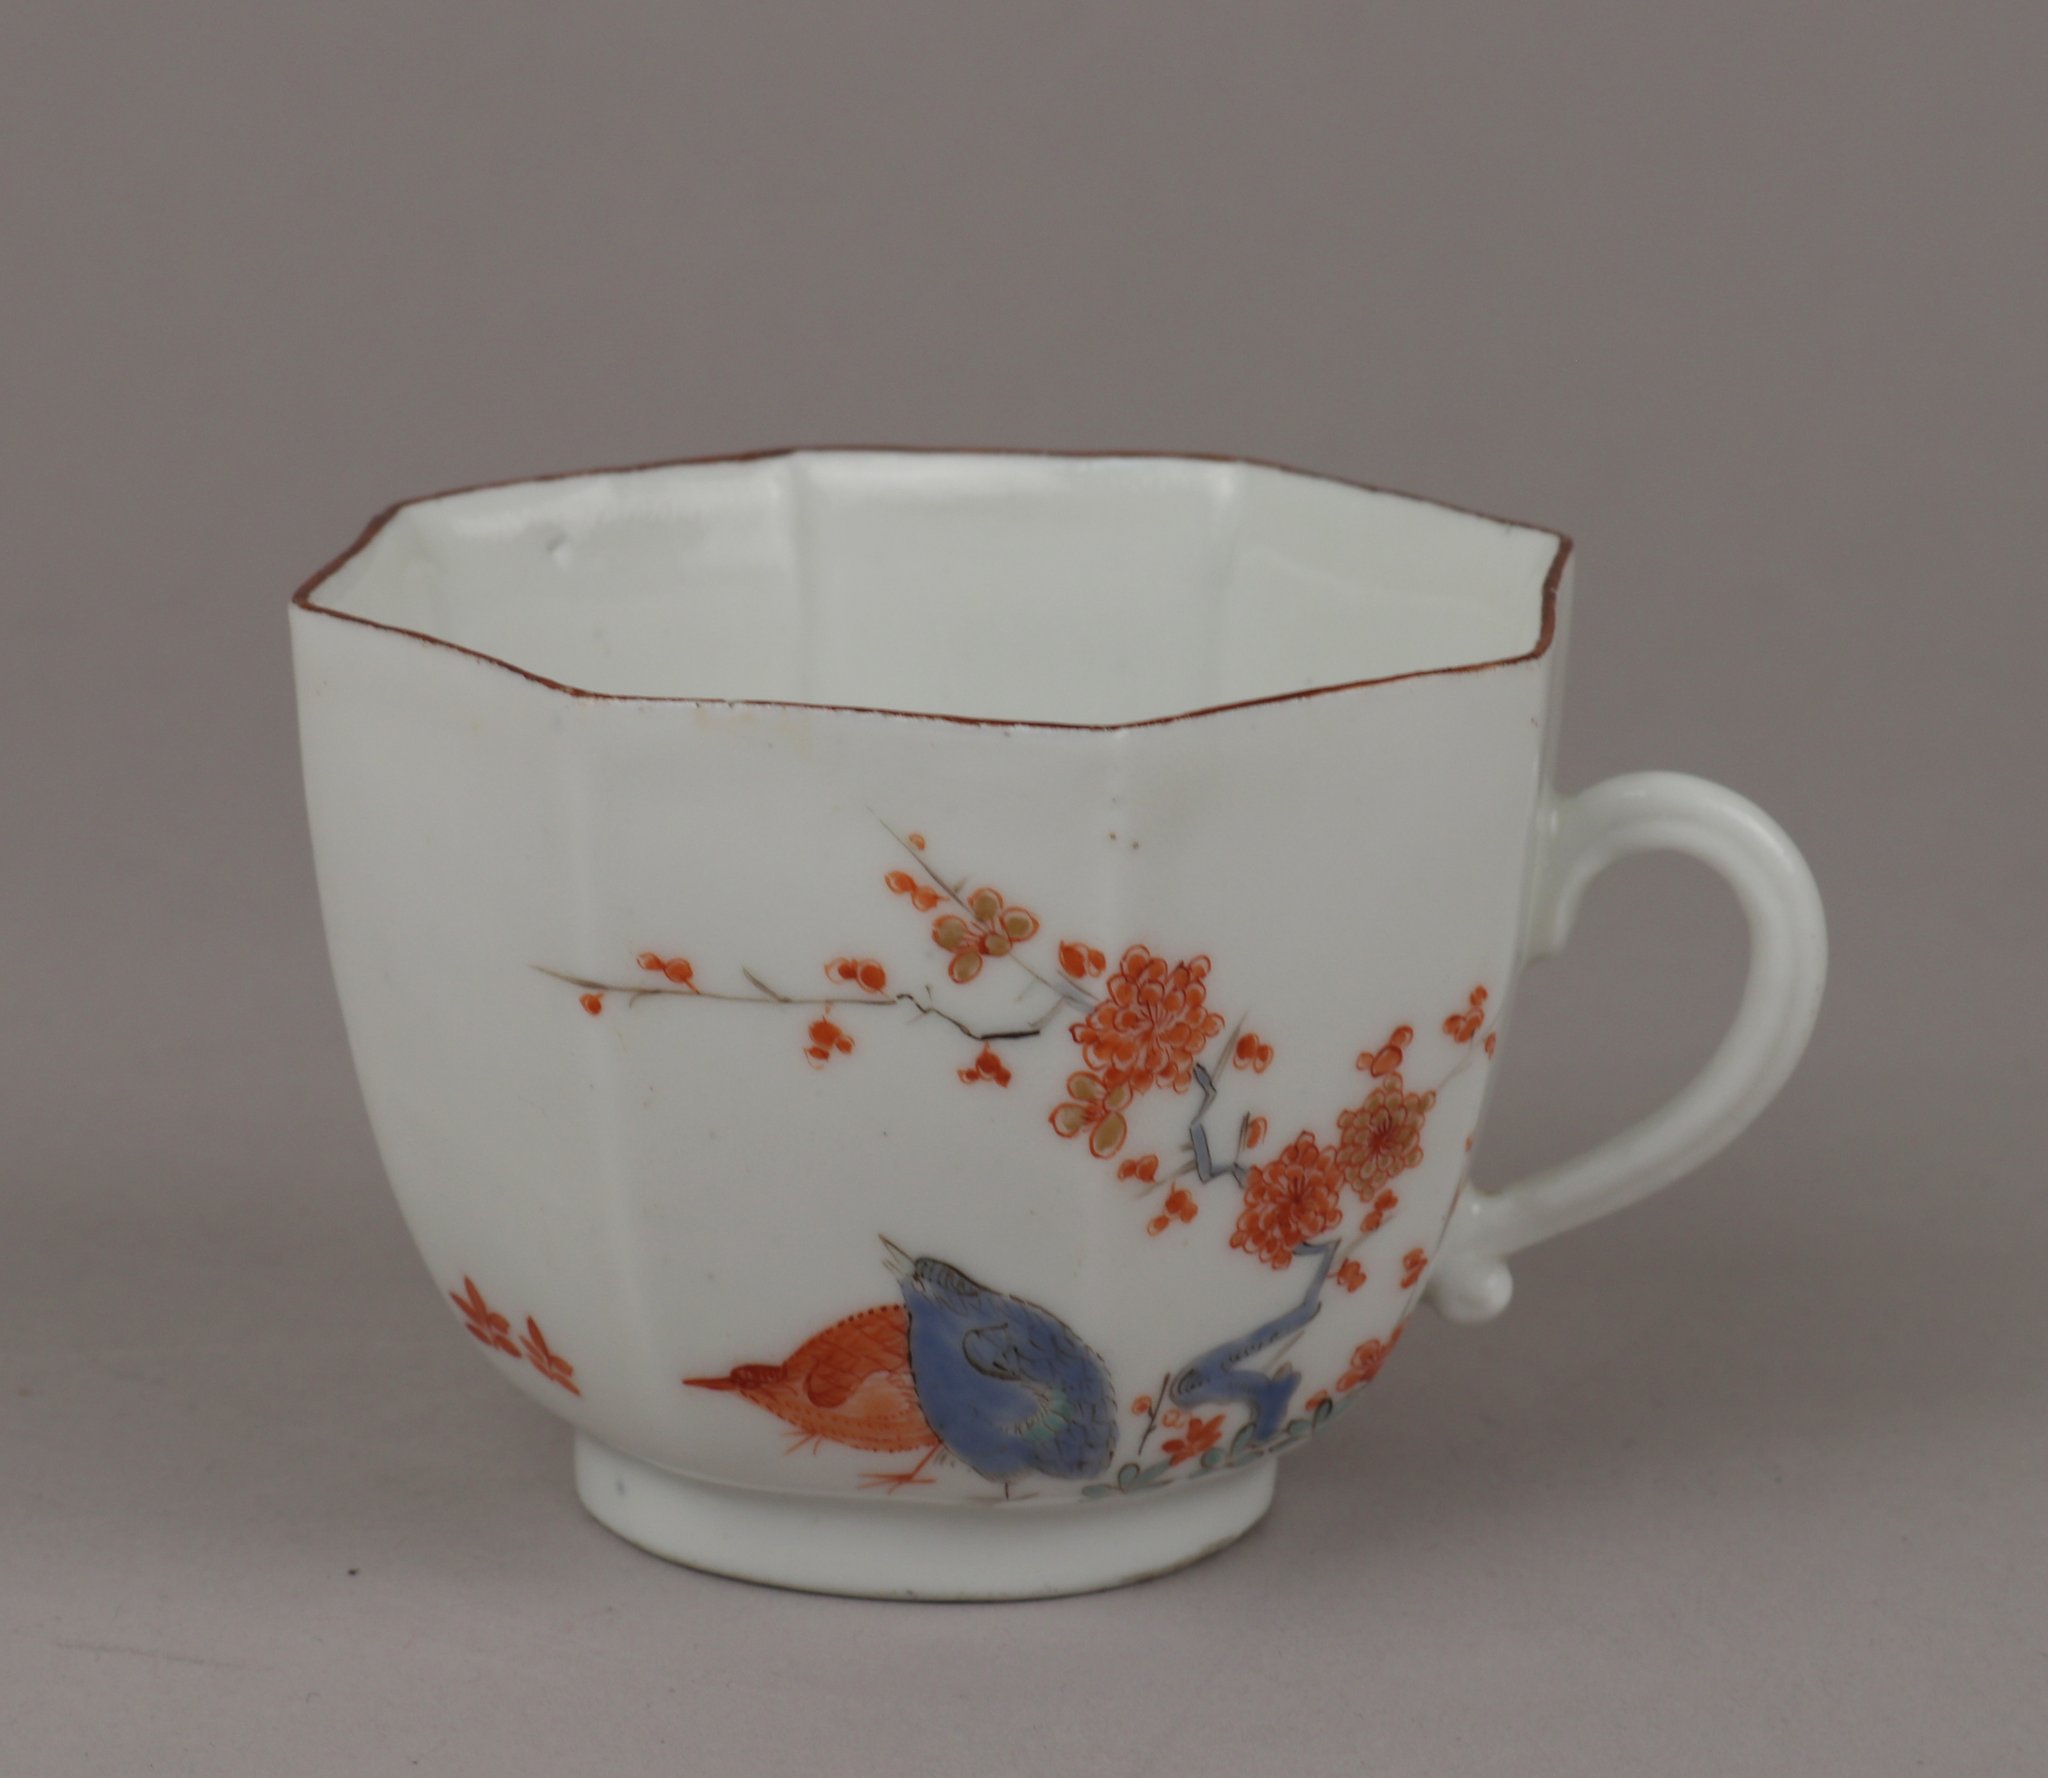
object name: cup and saucer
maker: meissen manufactory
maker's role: manufactory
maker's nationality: german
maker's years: 1710-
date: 1730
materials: hard paste porcelain